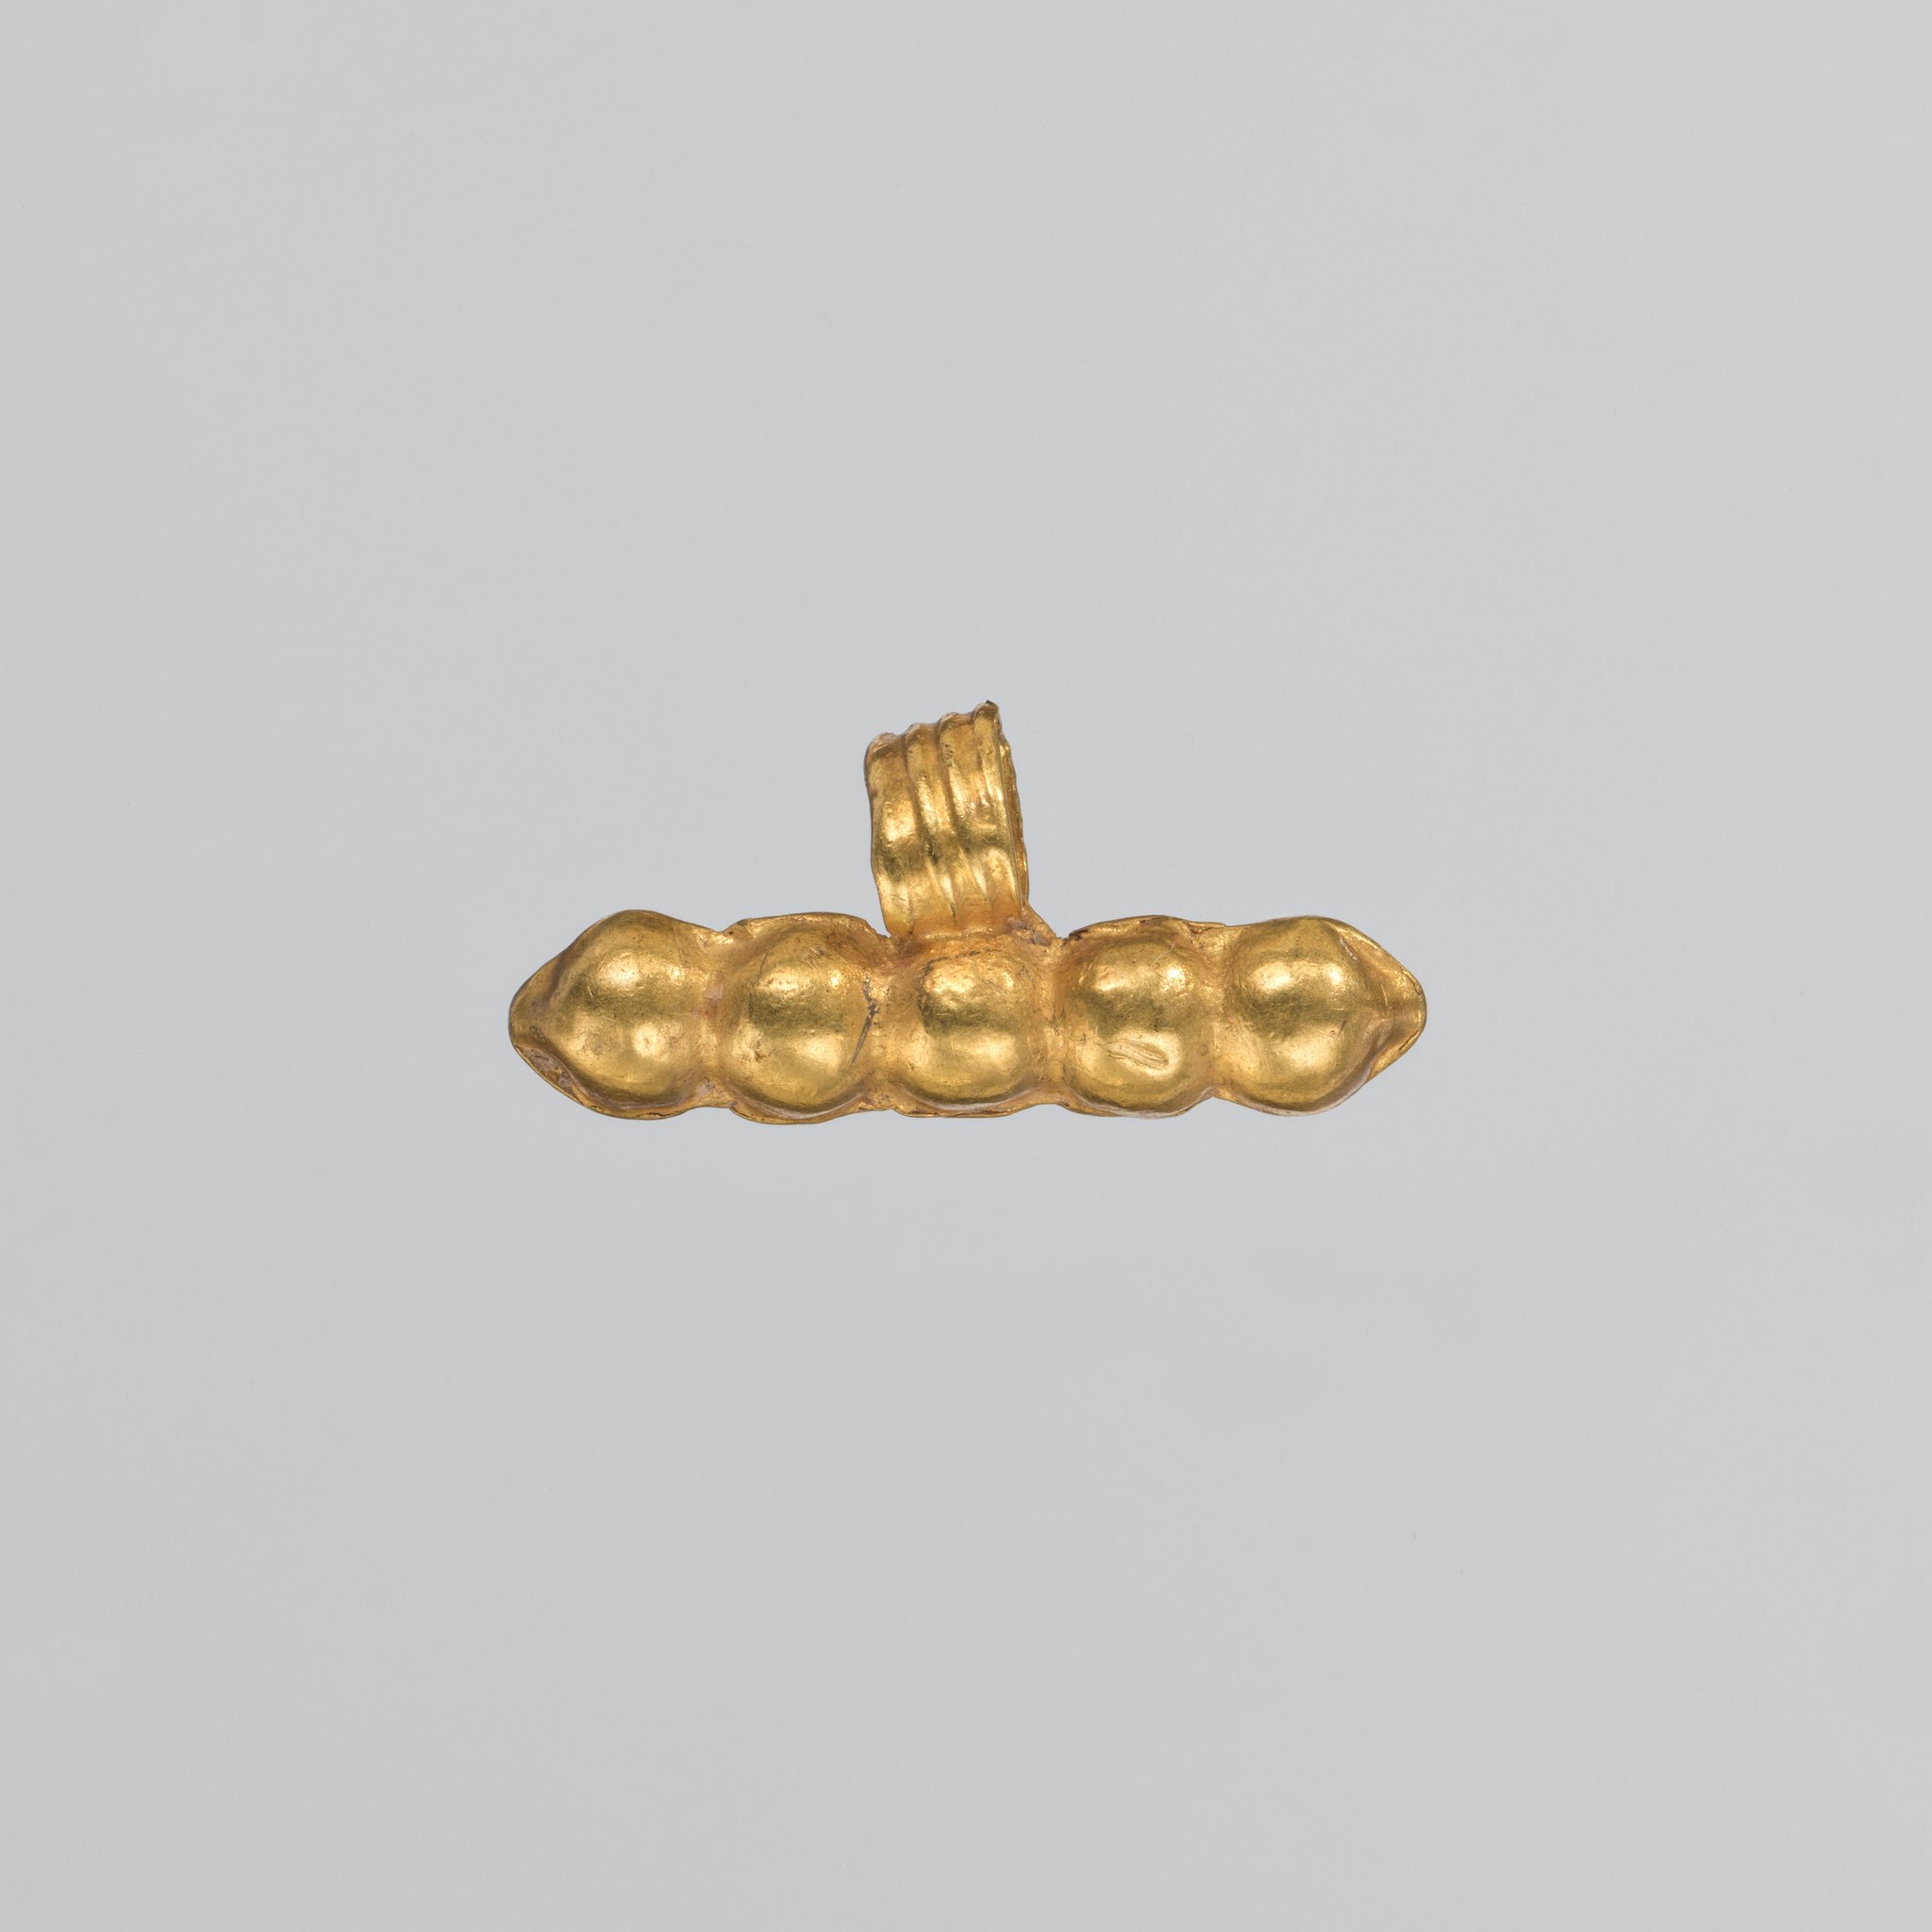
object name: bead pendant, tubular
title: Gold pendant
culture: cypro-phoenician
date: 700-501 BCE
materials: gold